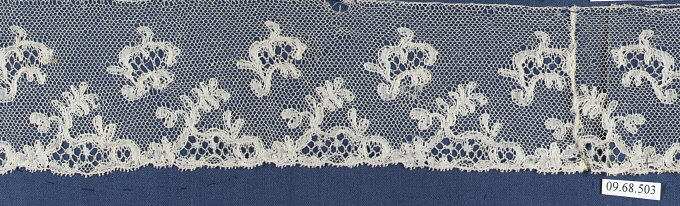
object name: fragment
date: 1801-1900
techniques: lace